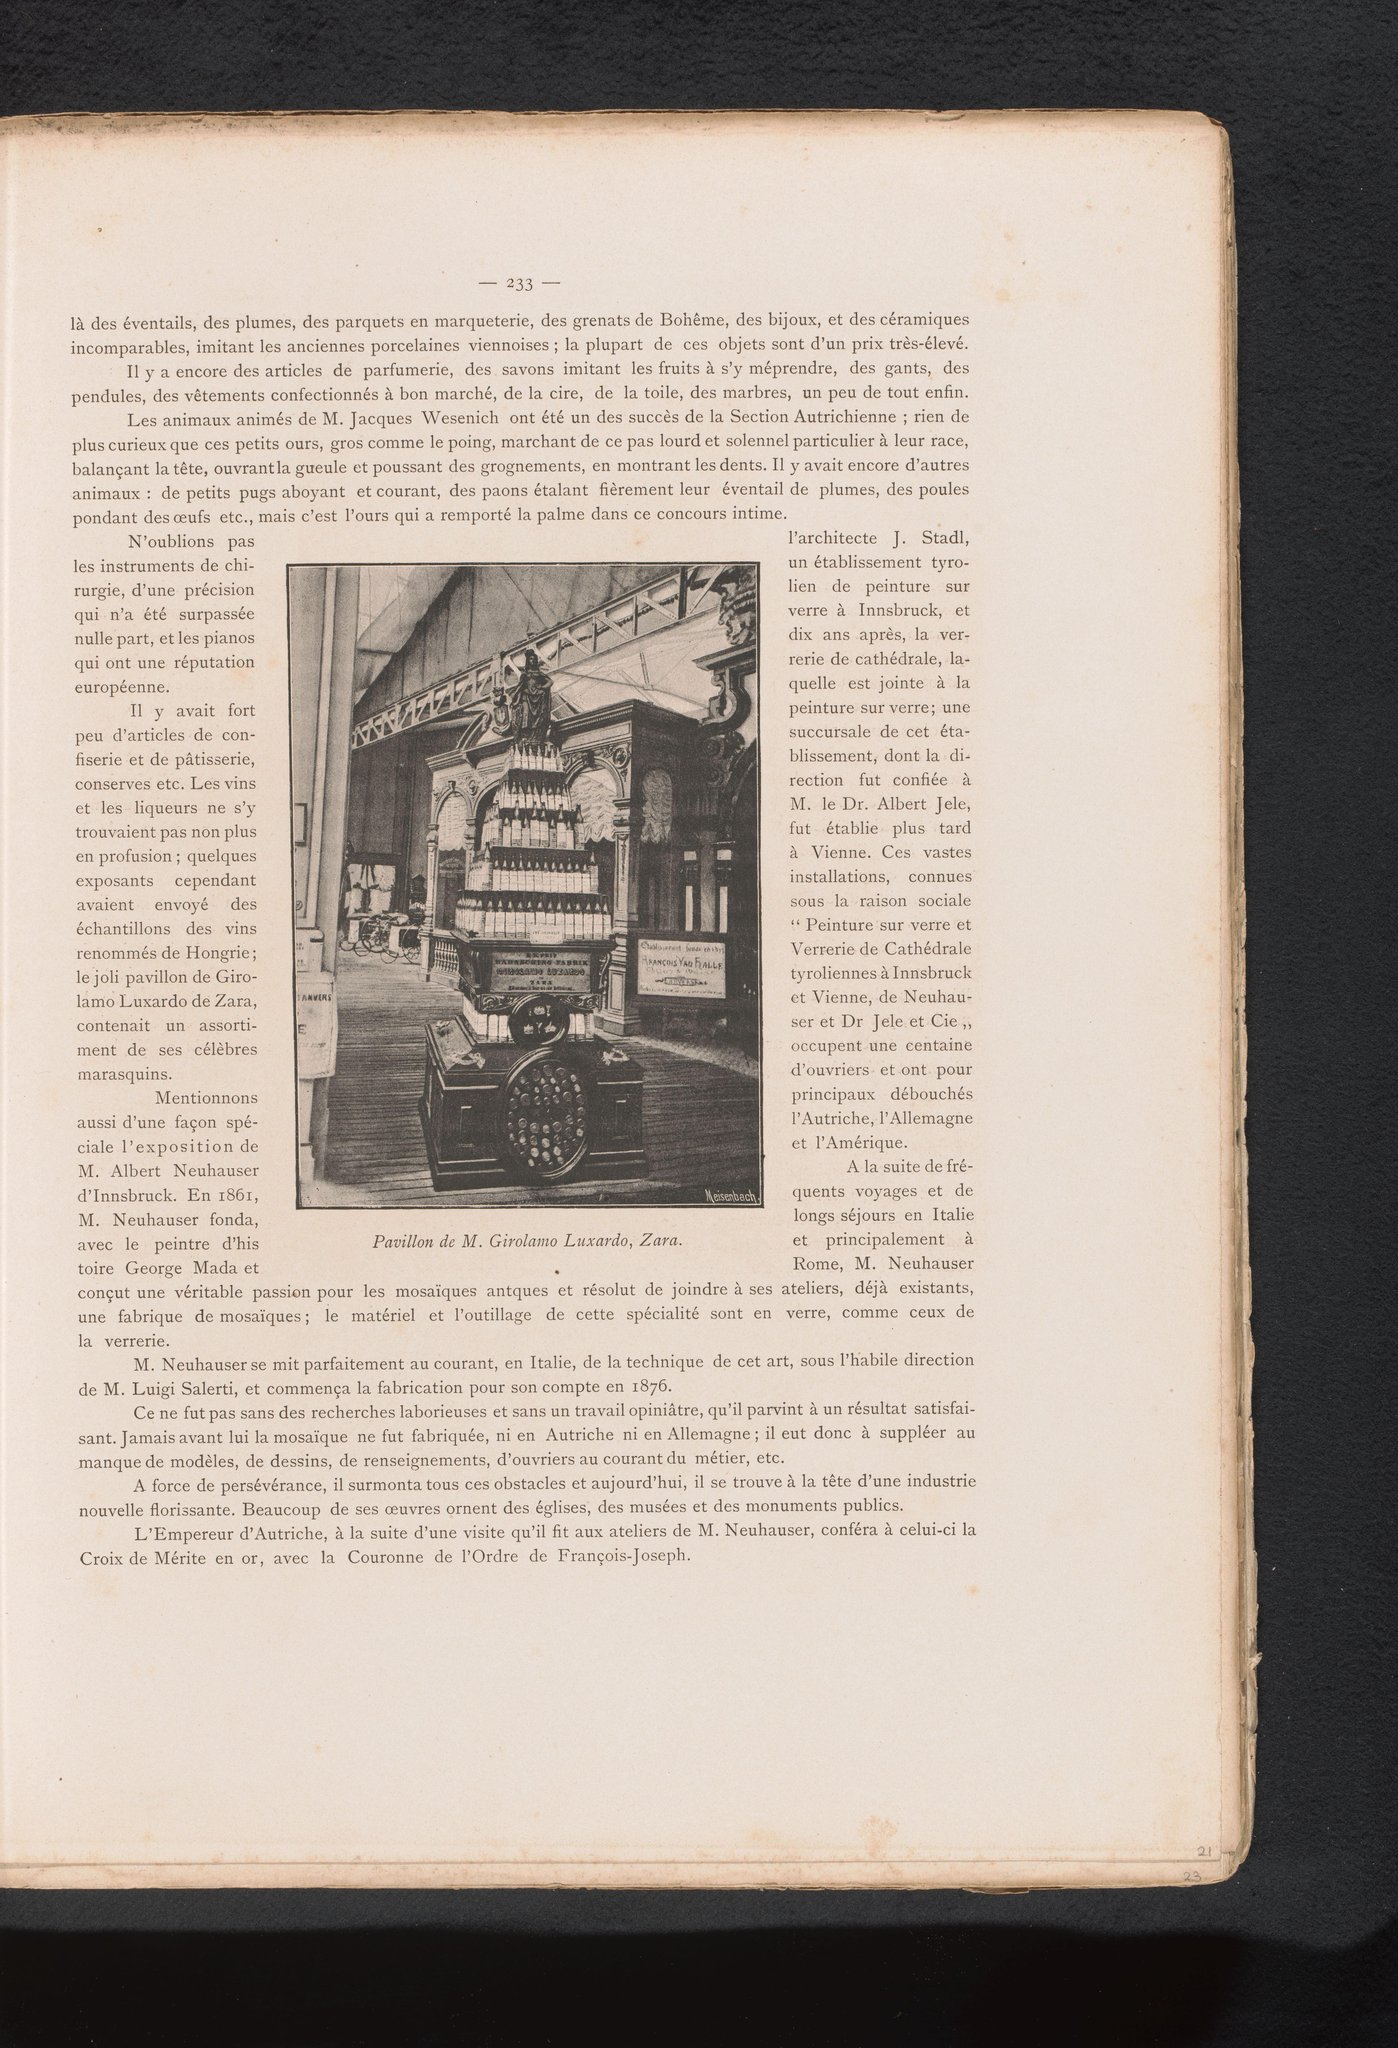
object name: page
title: Pavillon de M. Girolamo Luxardo, Zara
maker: Anonymous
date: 1880-1885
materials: paper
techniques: autotype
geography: antwerp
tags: world fair, world exhibition, antwerp